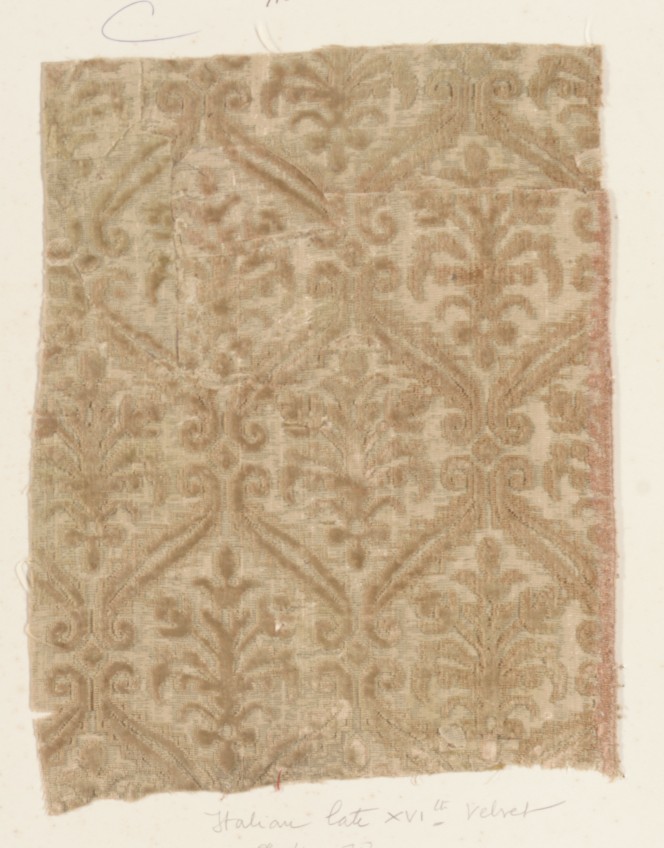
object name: fragment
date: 1567-1600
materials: metal thread, silk